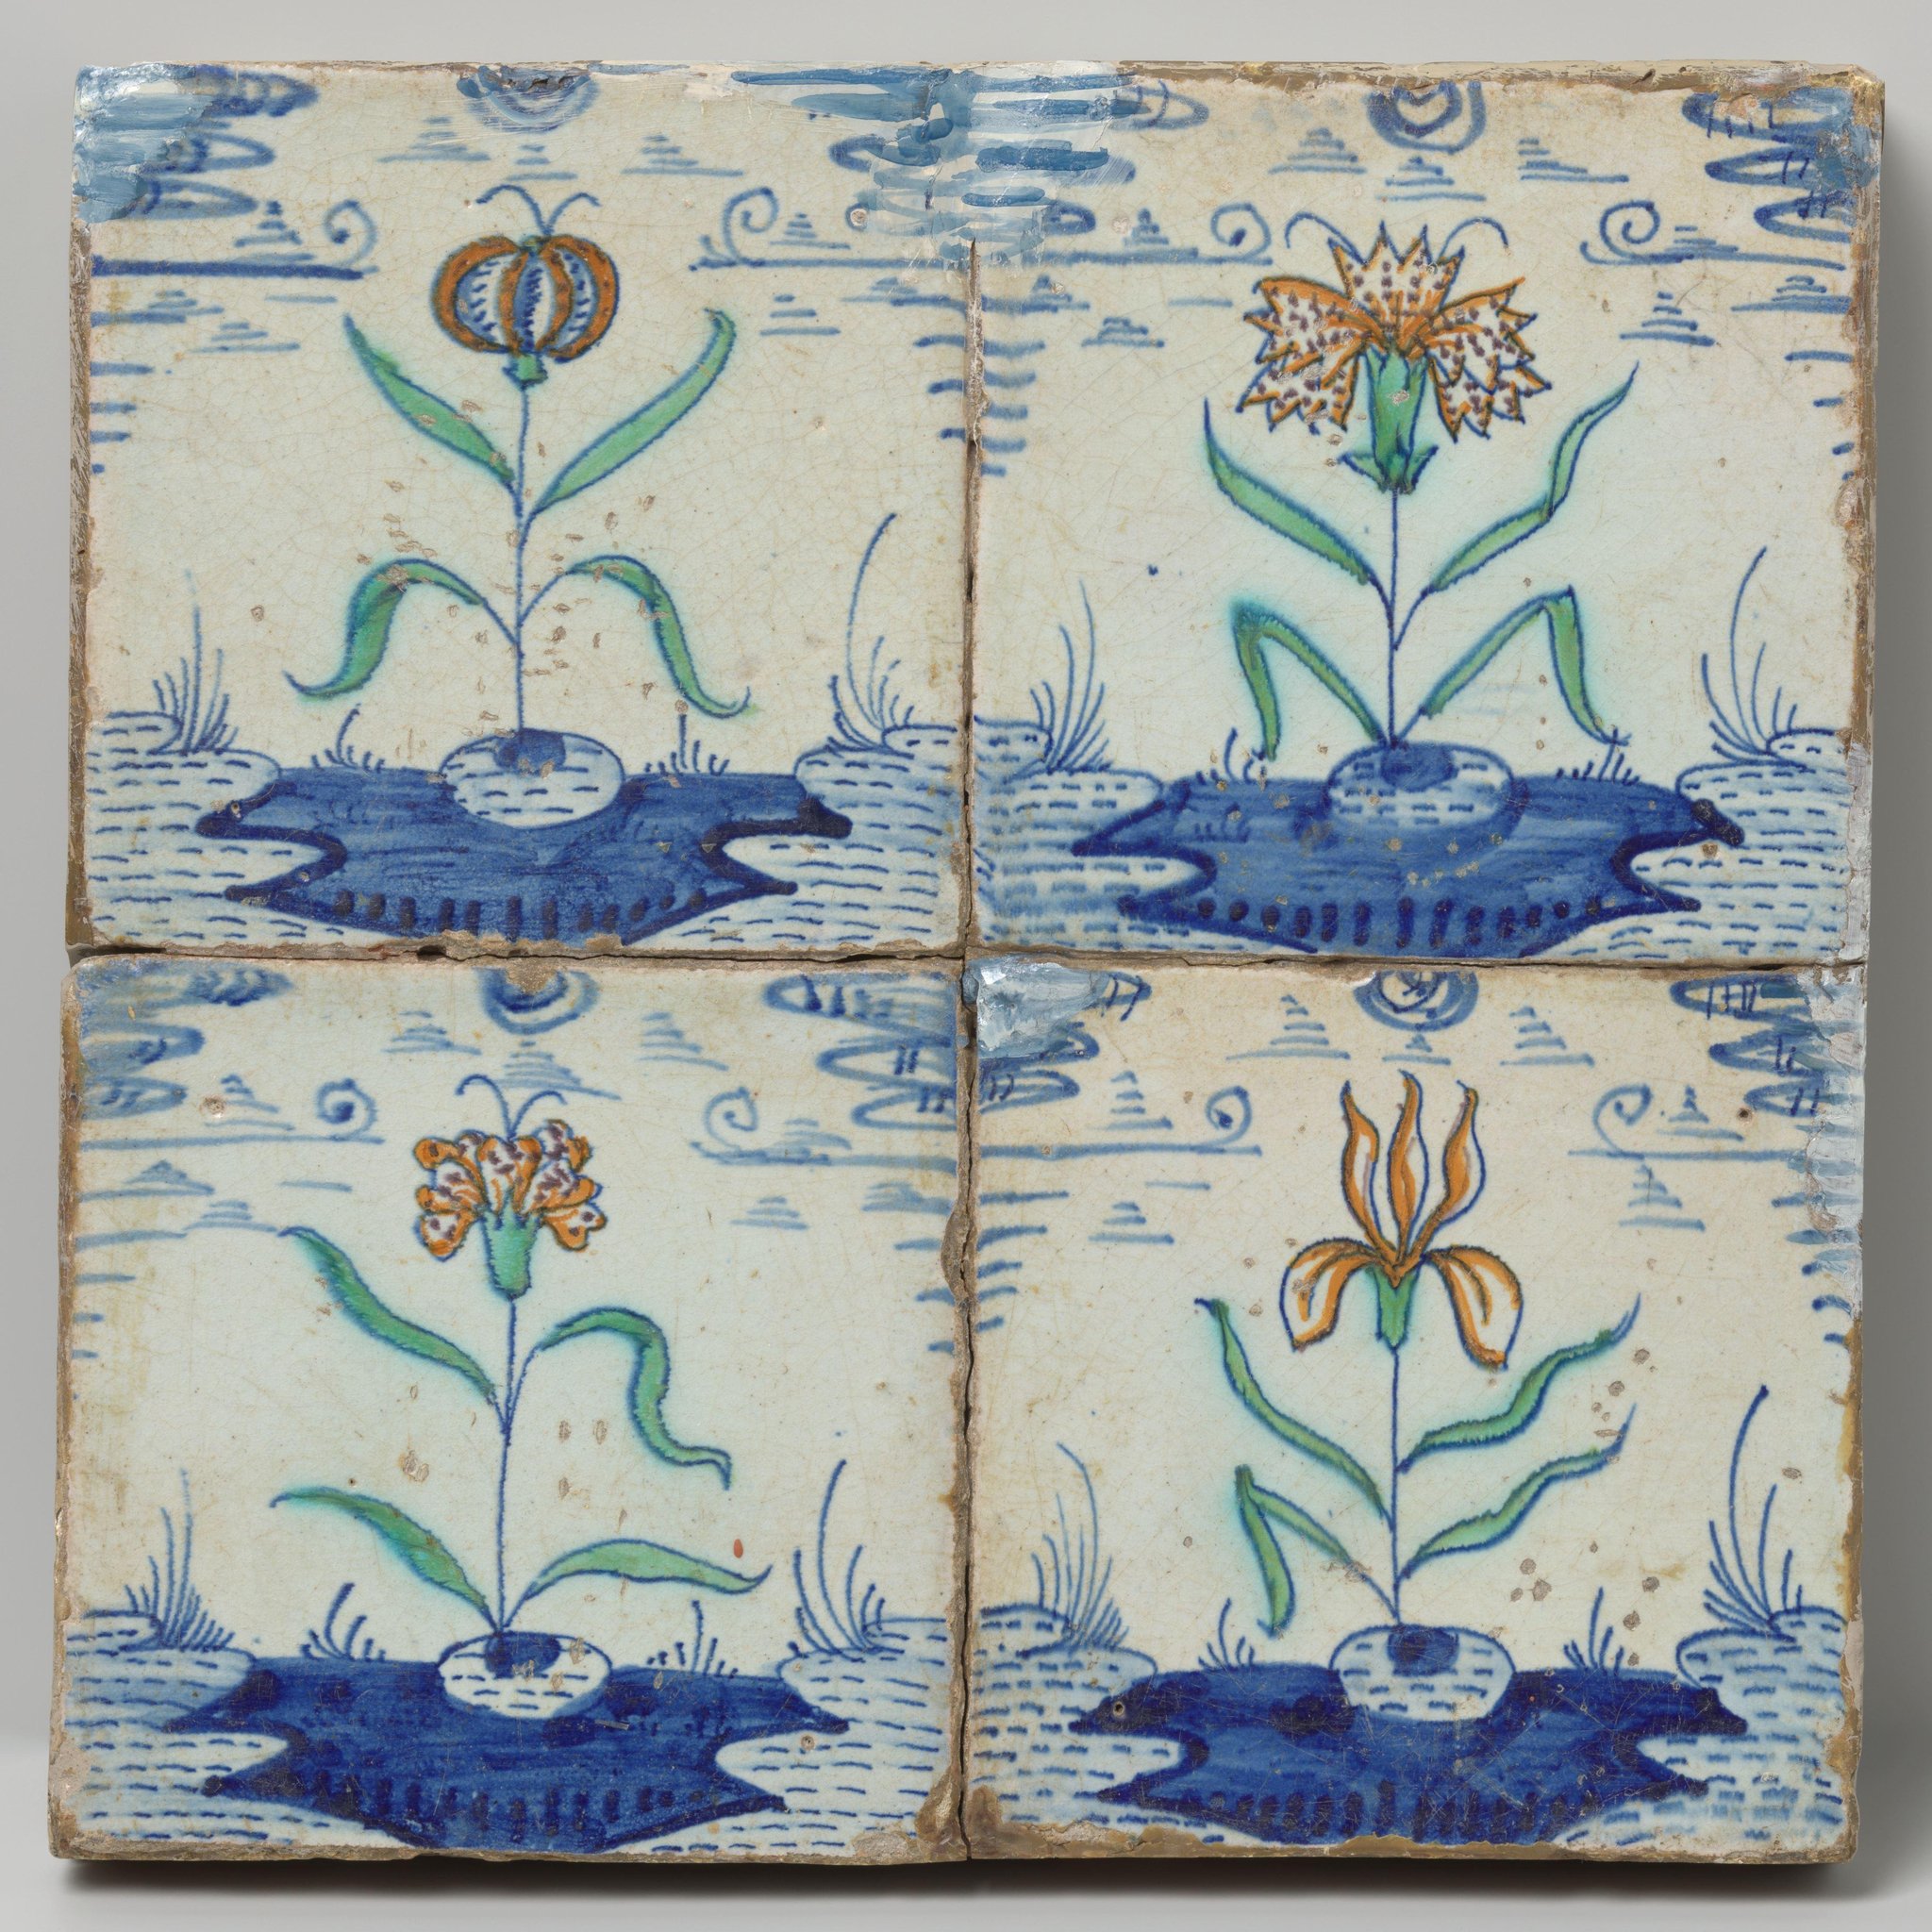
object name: tile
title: Veld van vier tegels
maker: Anonymous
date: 1620-1640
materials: earthenware, glaze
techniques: maiolica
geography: netherlands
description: Veld van vier tegels (2 x 2) elk met een veelkleurig (blauw, groen, oranje en paars) geschilderde bloem op een grond.